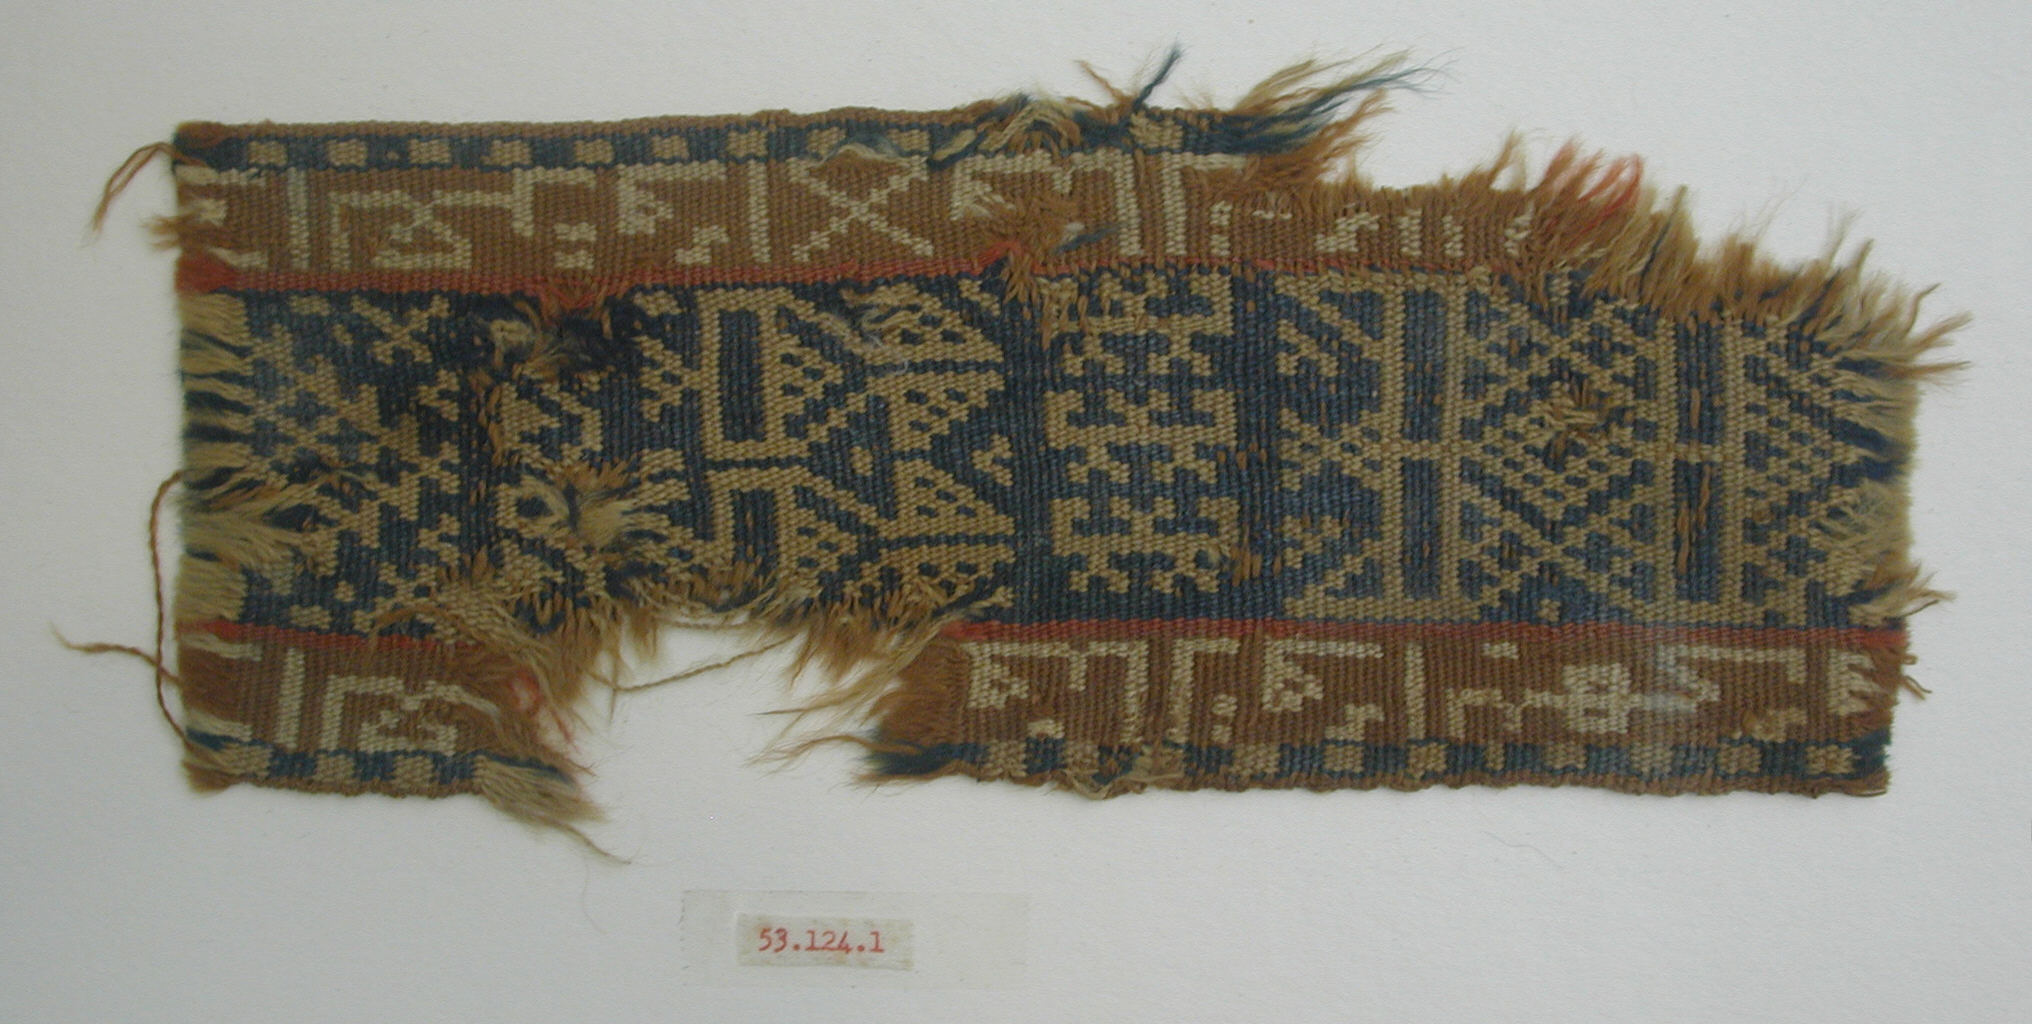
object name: band fragment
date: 1001-1200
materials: wool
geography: egypt